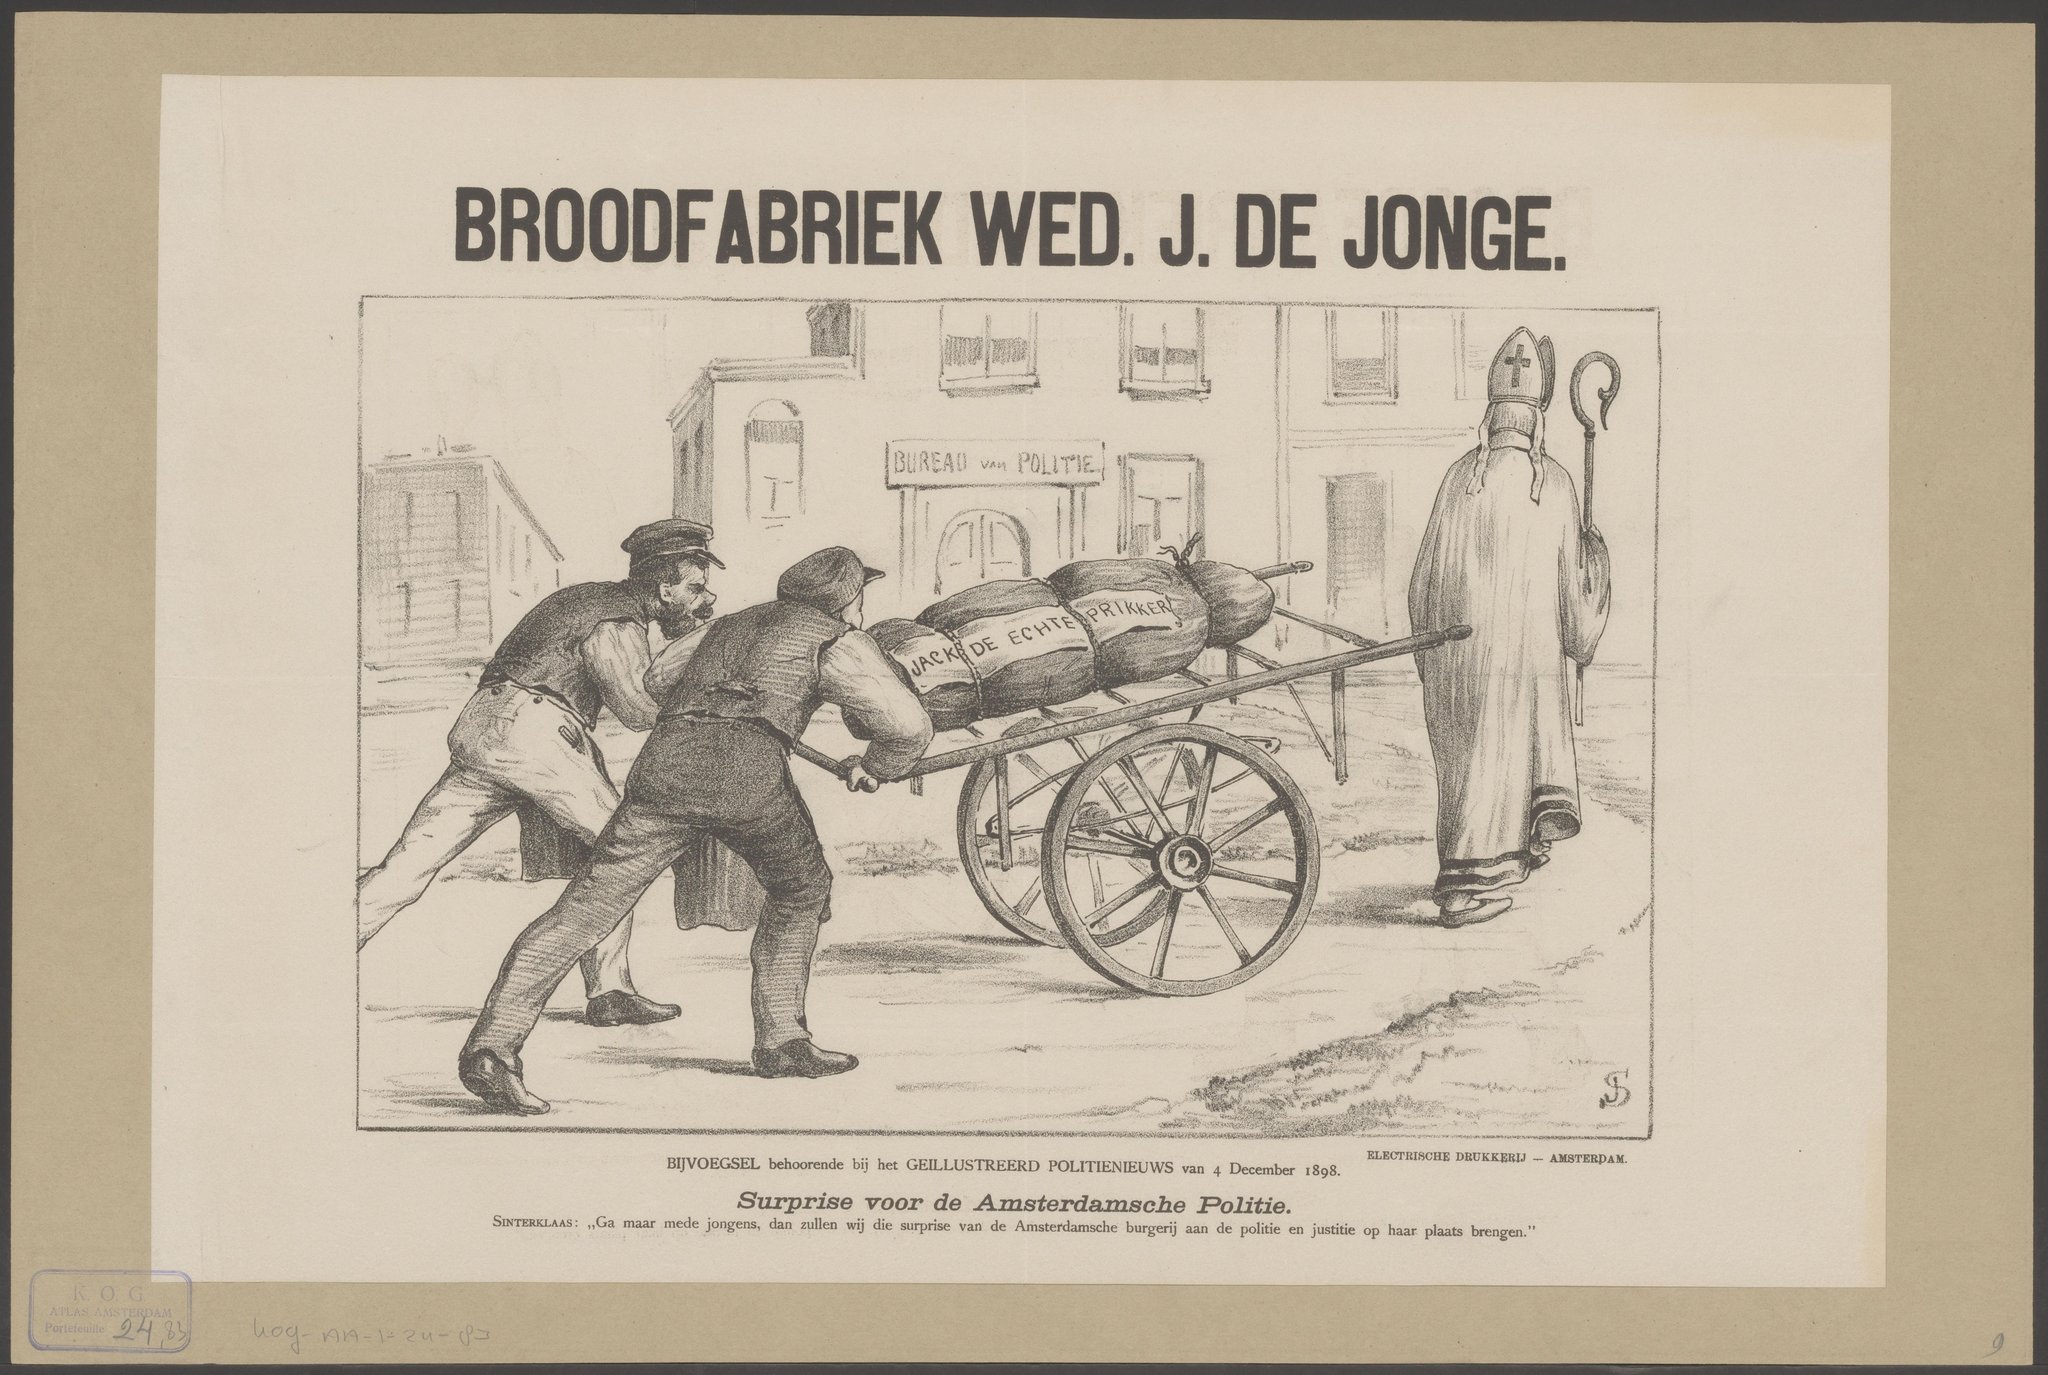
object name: cartoon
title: Surprise voor de Amsterdamsche Politie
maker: jan sluijters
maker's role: draughtsman, print maker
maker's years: 1881-1957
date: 1898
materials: paper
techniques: letterpress printing, lithograph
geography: amsterdam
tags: hand-cart, the bishop nicholas of myra (or bari); possible attributes: anchor, boat, three golden balls (on a book), three purses, three children in a tub, three maidens, police, amsterdam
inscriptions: collector's mark: Lugt 1641b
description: Gepubliceerd als bijvoegsel van 'Het Geïllustreerd Politienieuws', 4 december 1898.